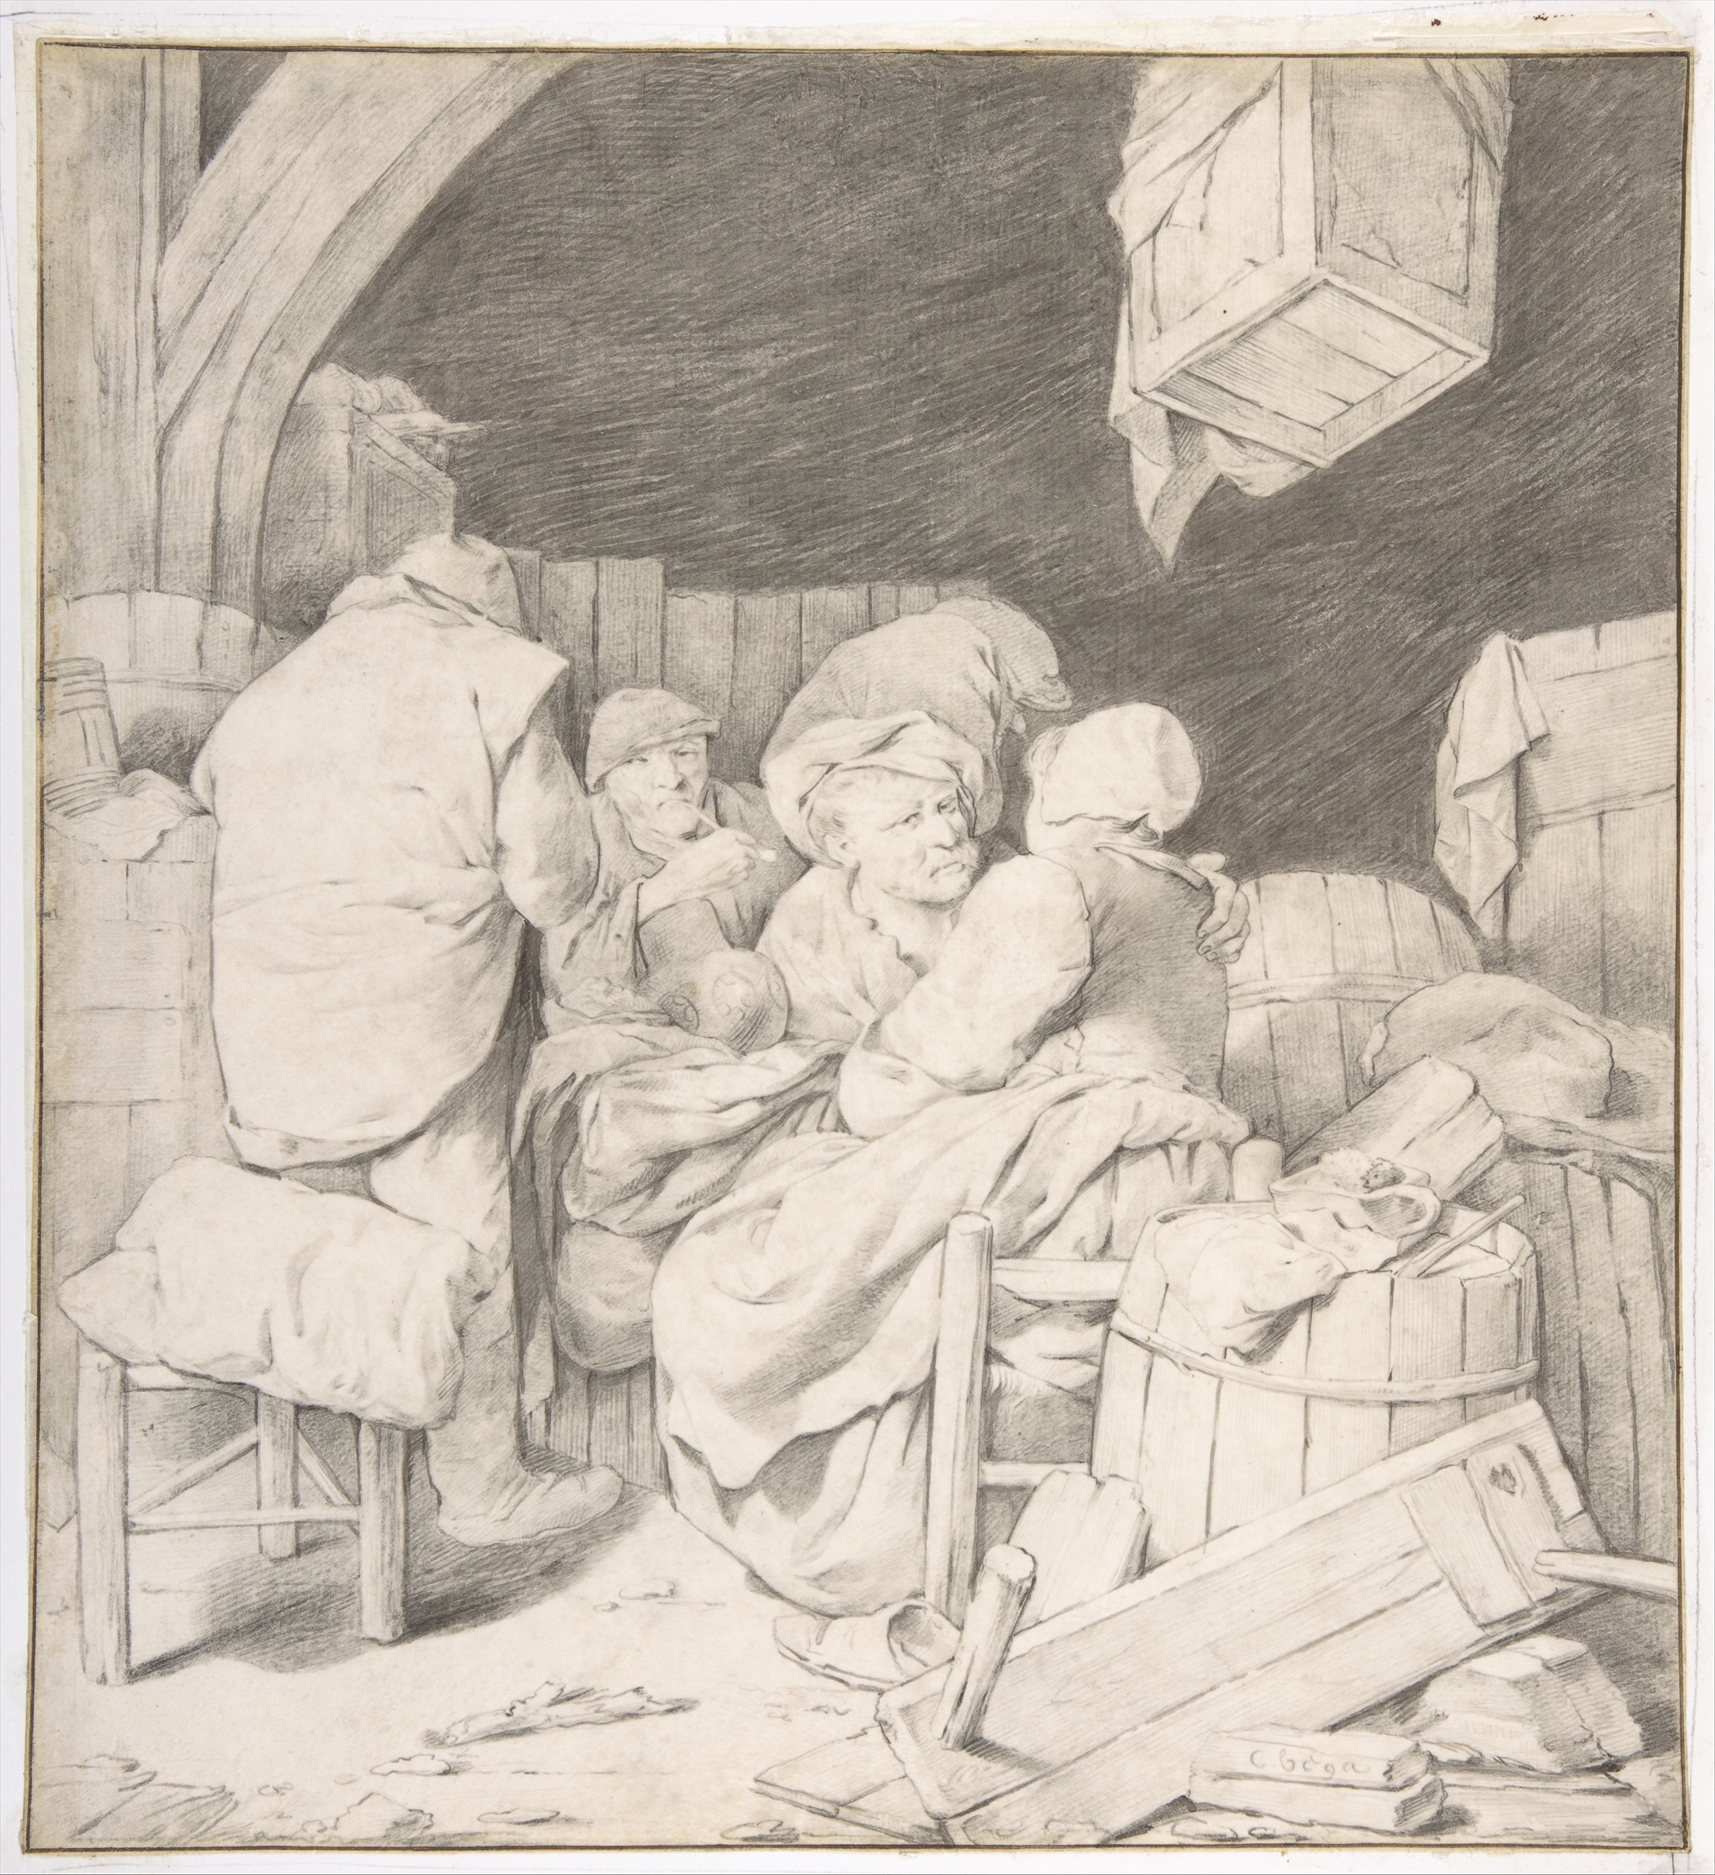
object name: drawing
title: Peasants Gathered at an Inn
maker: cornelis bega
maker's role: artist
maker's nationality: dutch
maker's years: 1631-1664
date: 1634-1666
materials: chalk, parchment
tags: men,women